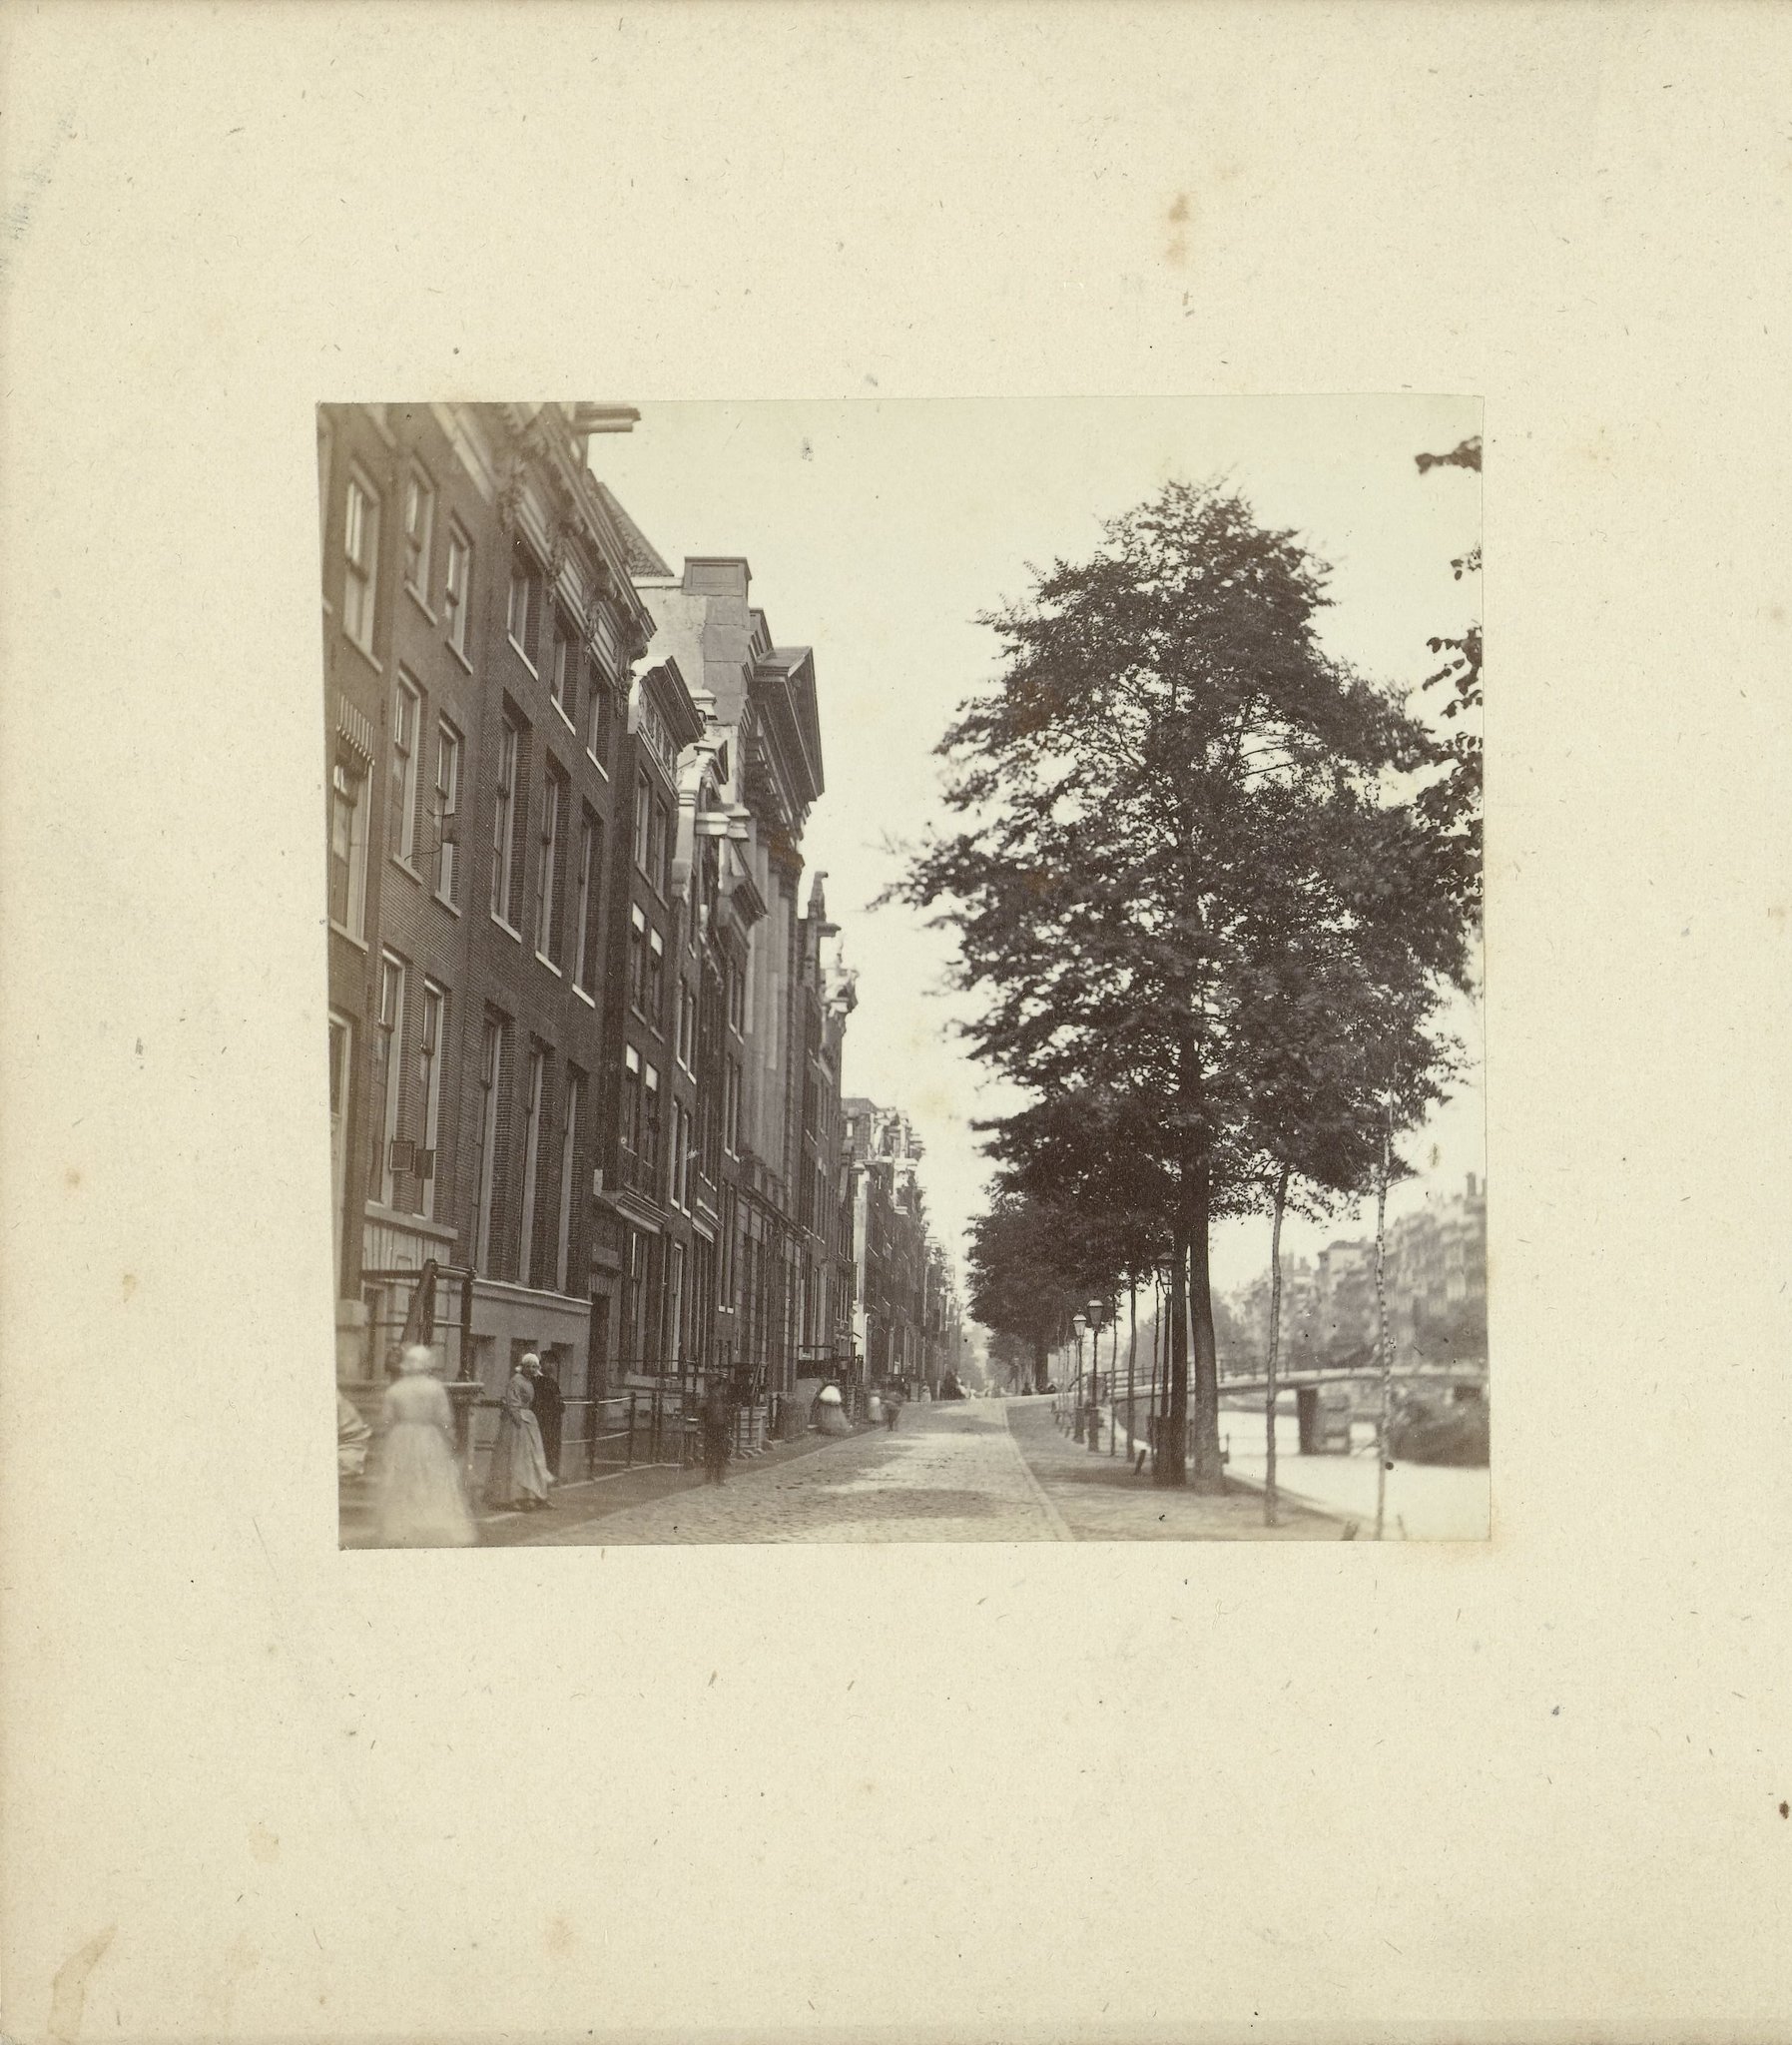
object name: photograph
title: De Keizersgracht bij de Beerenstraat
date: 1860-1875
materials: cardboard, paper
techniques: albumen print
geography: amsterdam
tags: street